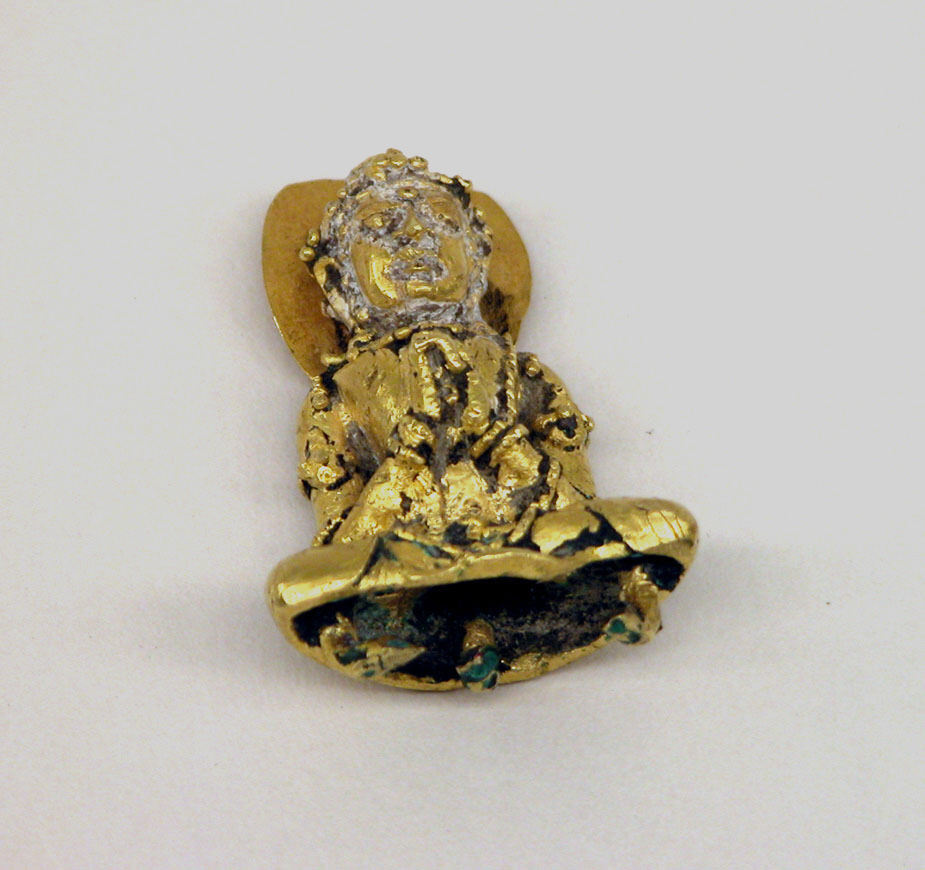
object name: figurine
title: Sculpture of Vairochana with Attached Nimbus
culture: indonesian, javanese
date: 901-1100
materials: gold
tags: buddhism,buddha